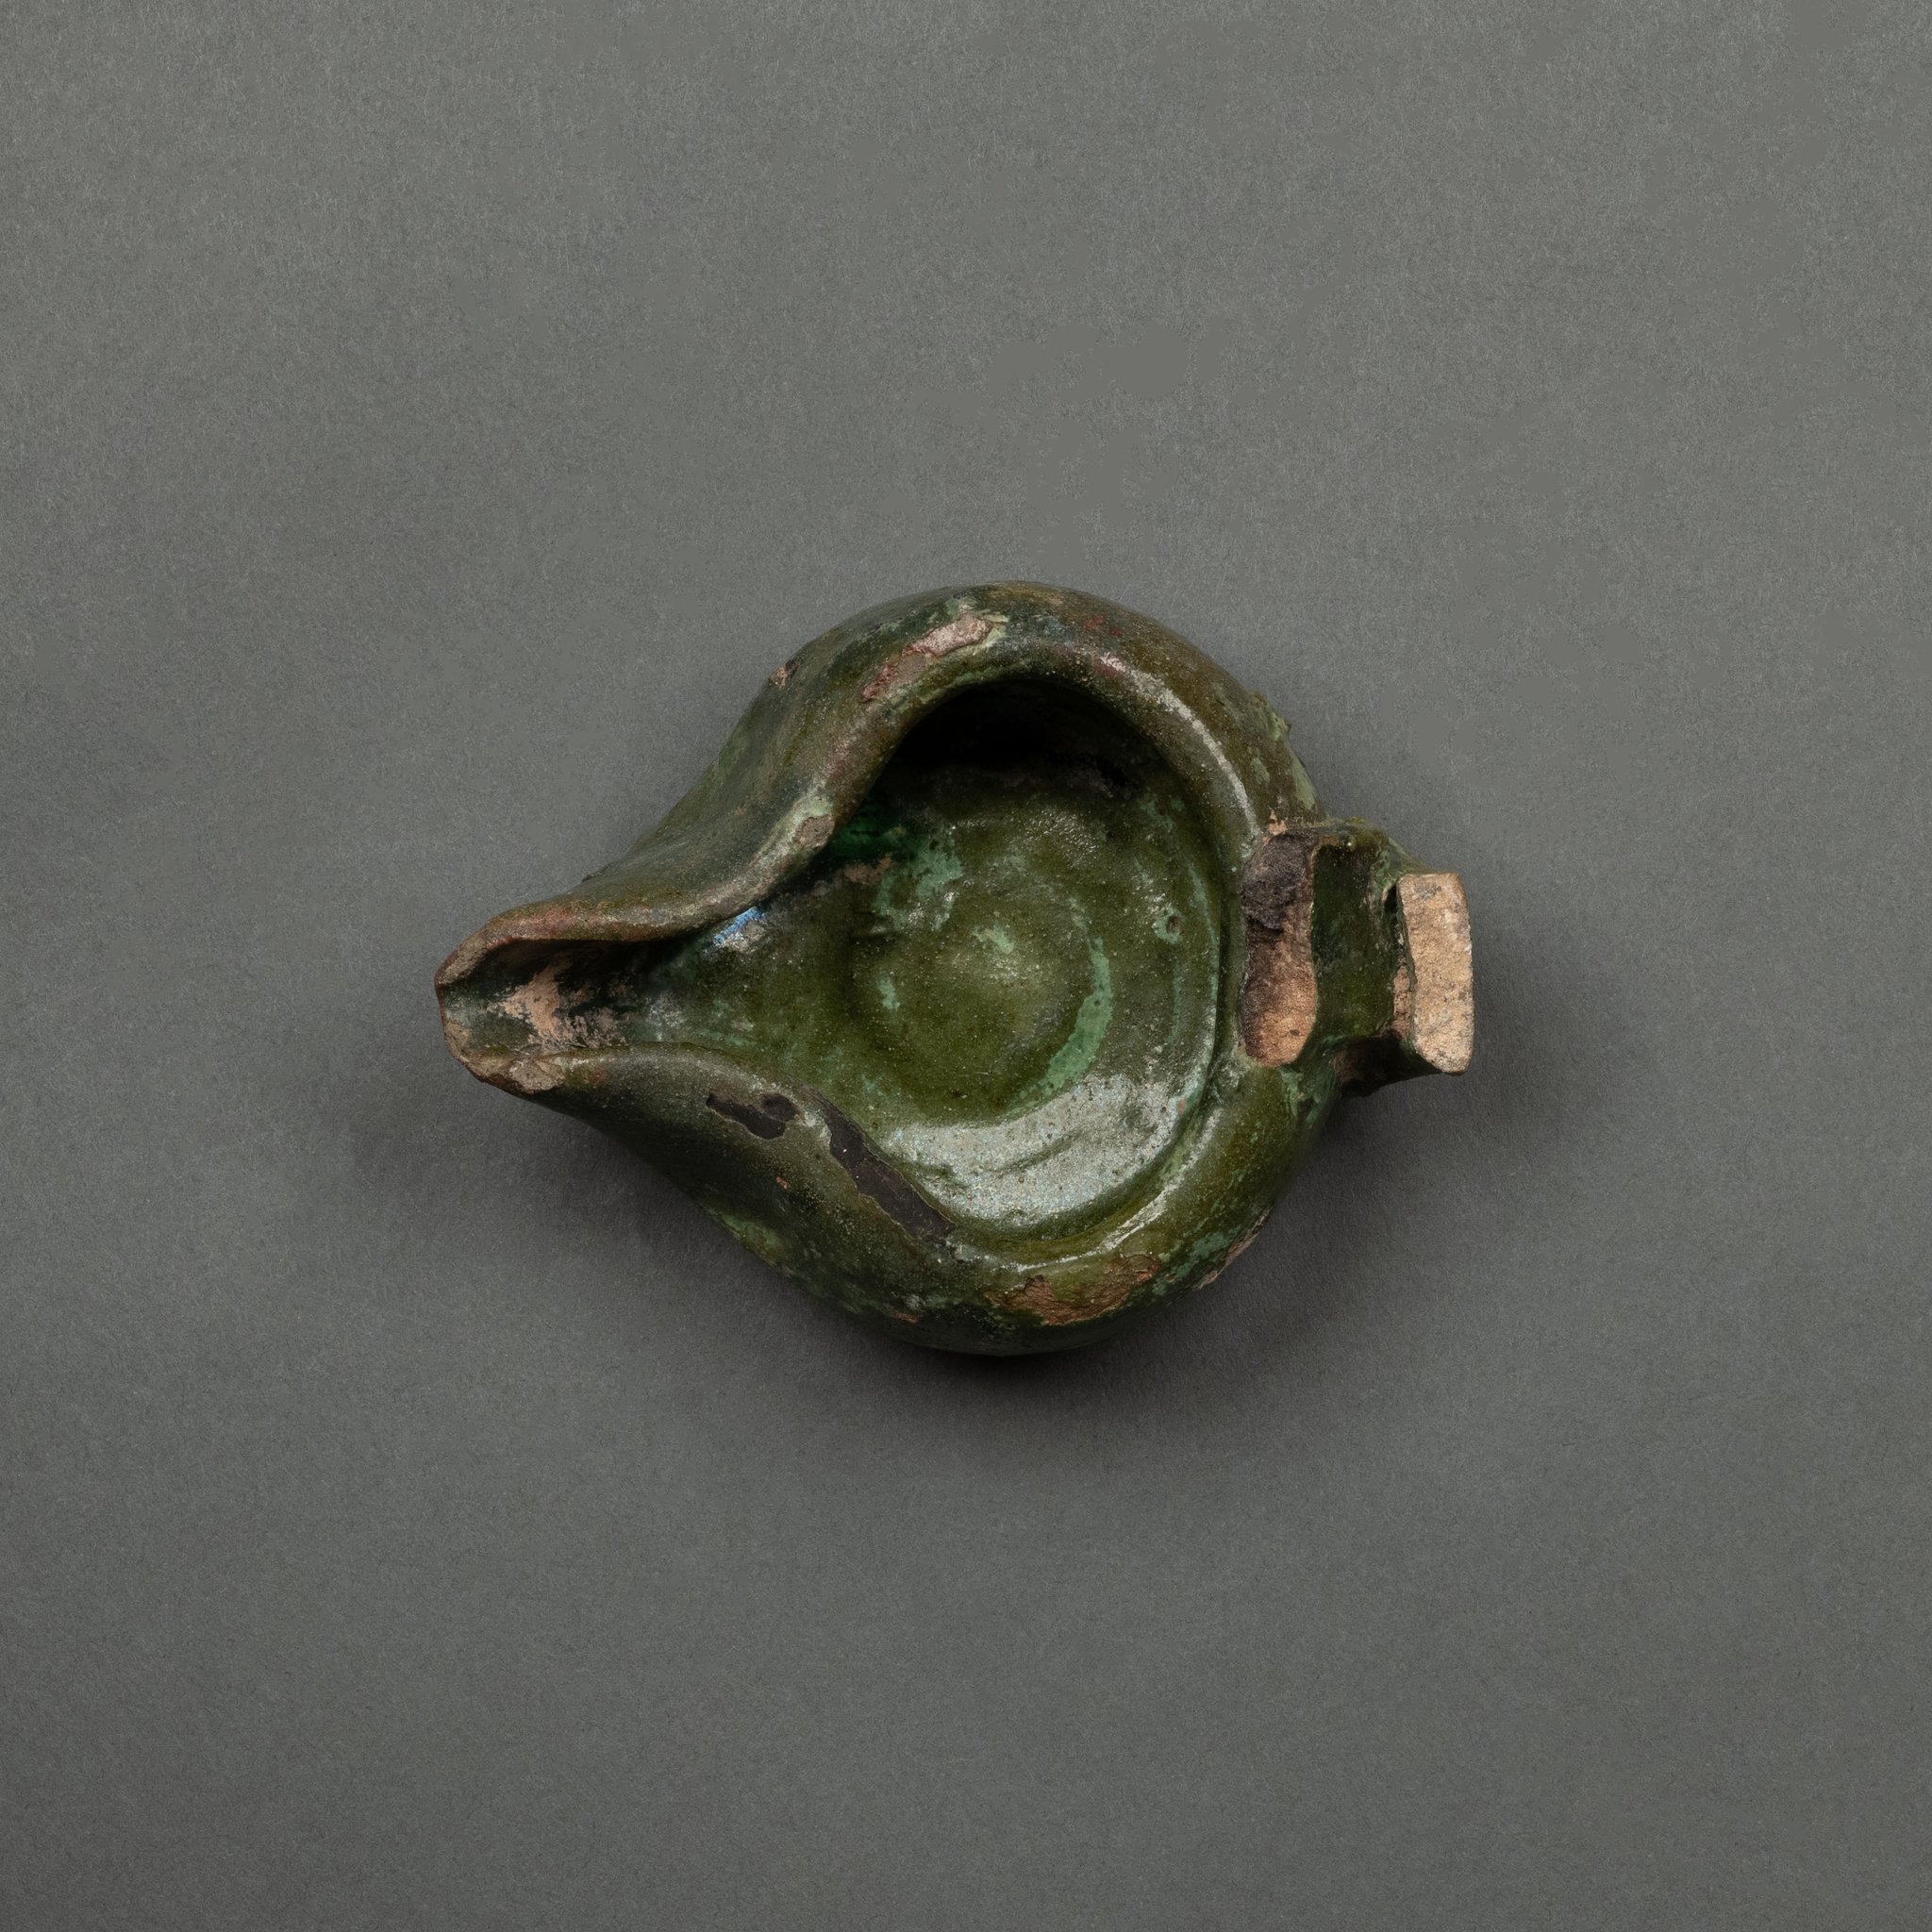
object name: lamp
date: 801-1000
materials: earthenware, glaze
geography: iran